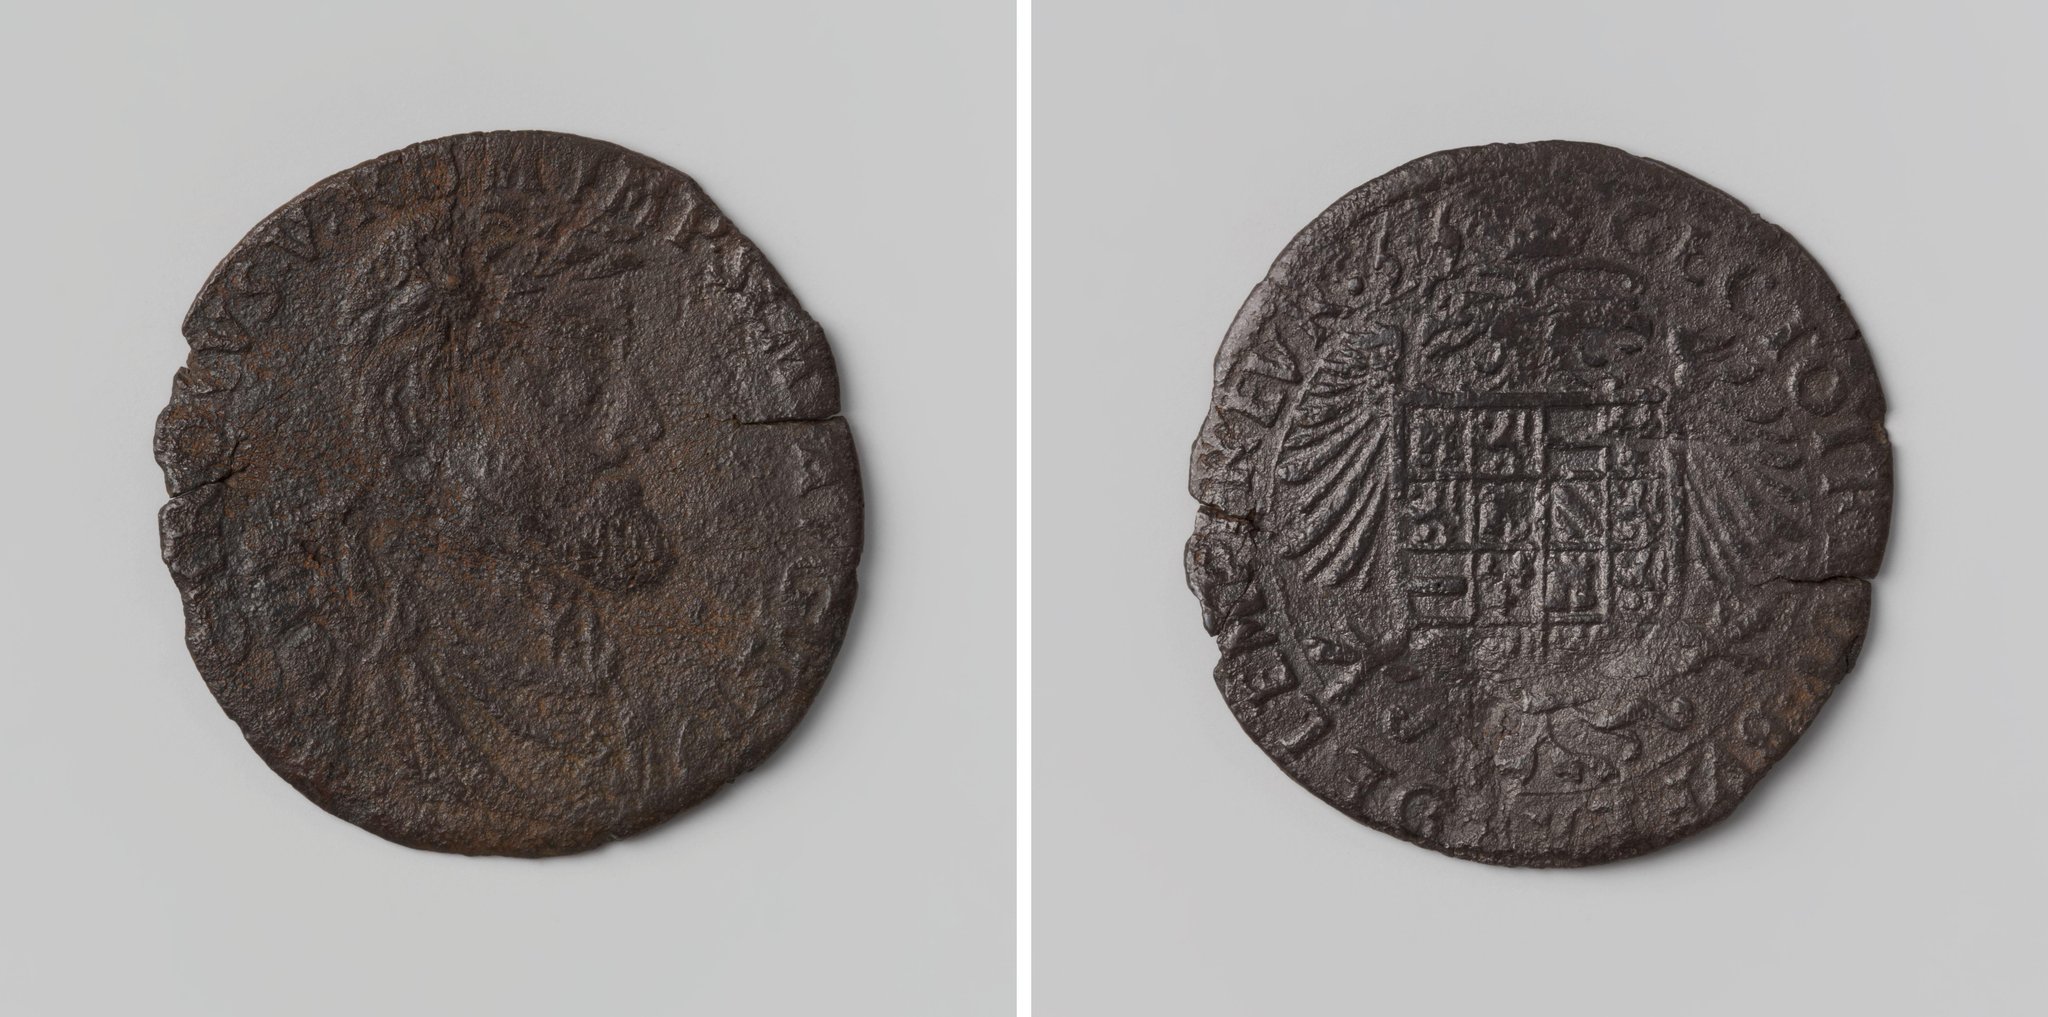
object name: jeton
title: Karel V, Duits keizer, rekenpenning van het bureau van de keizer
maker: Anonymous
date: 1555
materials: copper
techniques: striking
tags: ghent, charles v (holy roman emperor and king of spain)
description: Koperen penning. Voorzijde: borststuk man met lauwerkrans binnen omschrift. Keerzijde: tweekoppige adelaar onder kroon met wapenschild op borst binnen omschrift